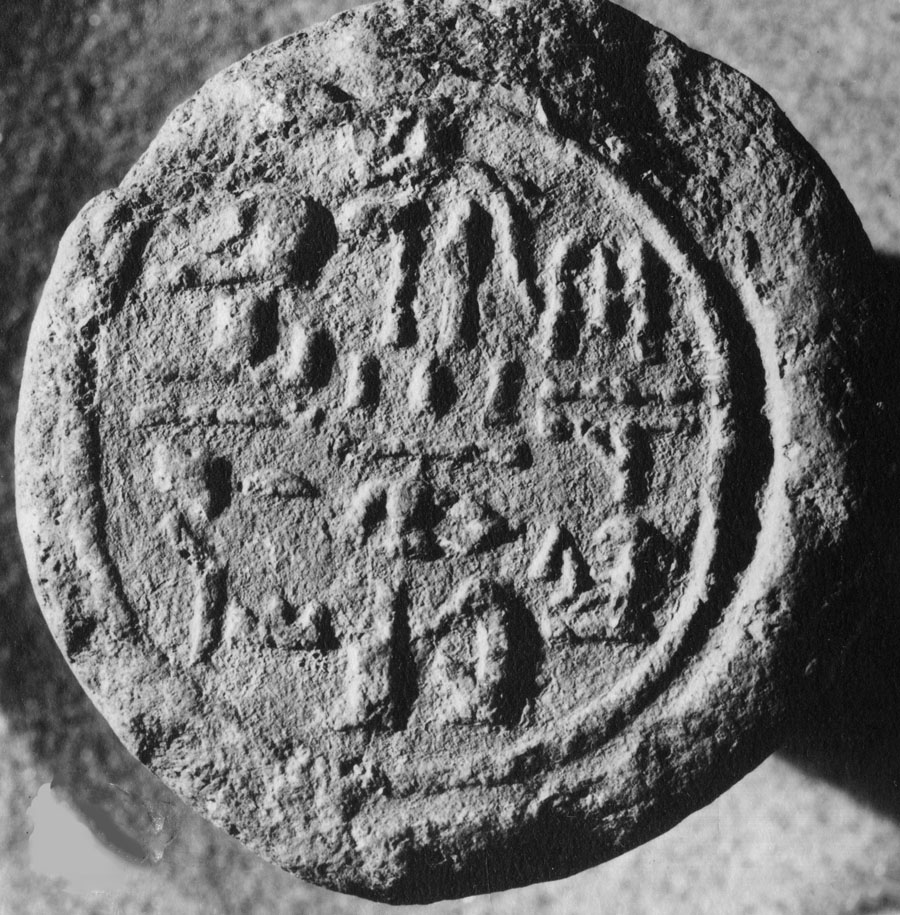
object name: cone, circular impression, min, scribe, overseer, priest, osiris, oasis, tt 109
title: Funerary Cone the Scribe Min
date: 1479-1425 BCE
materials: pottery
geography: egypt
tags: hieroglyphs